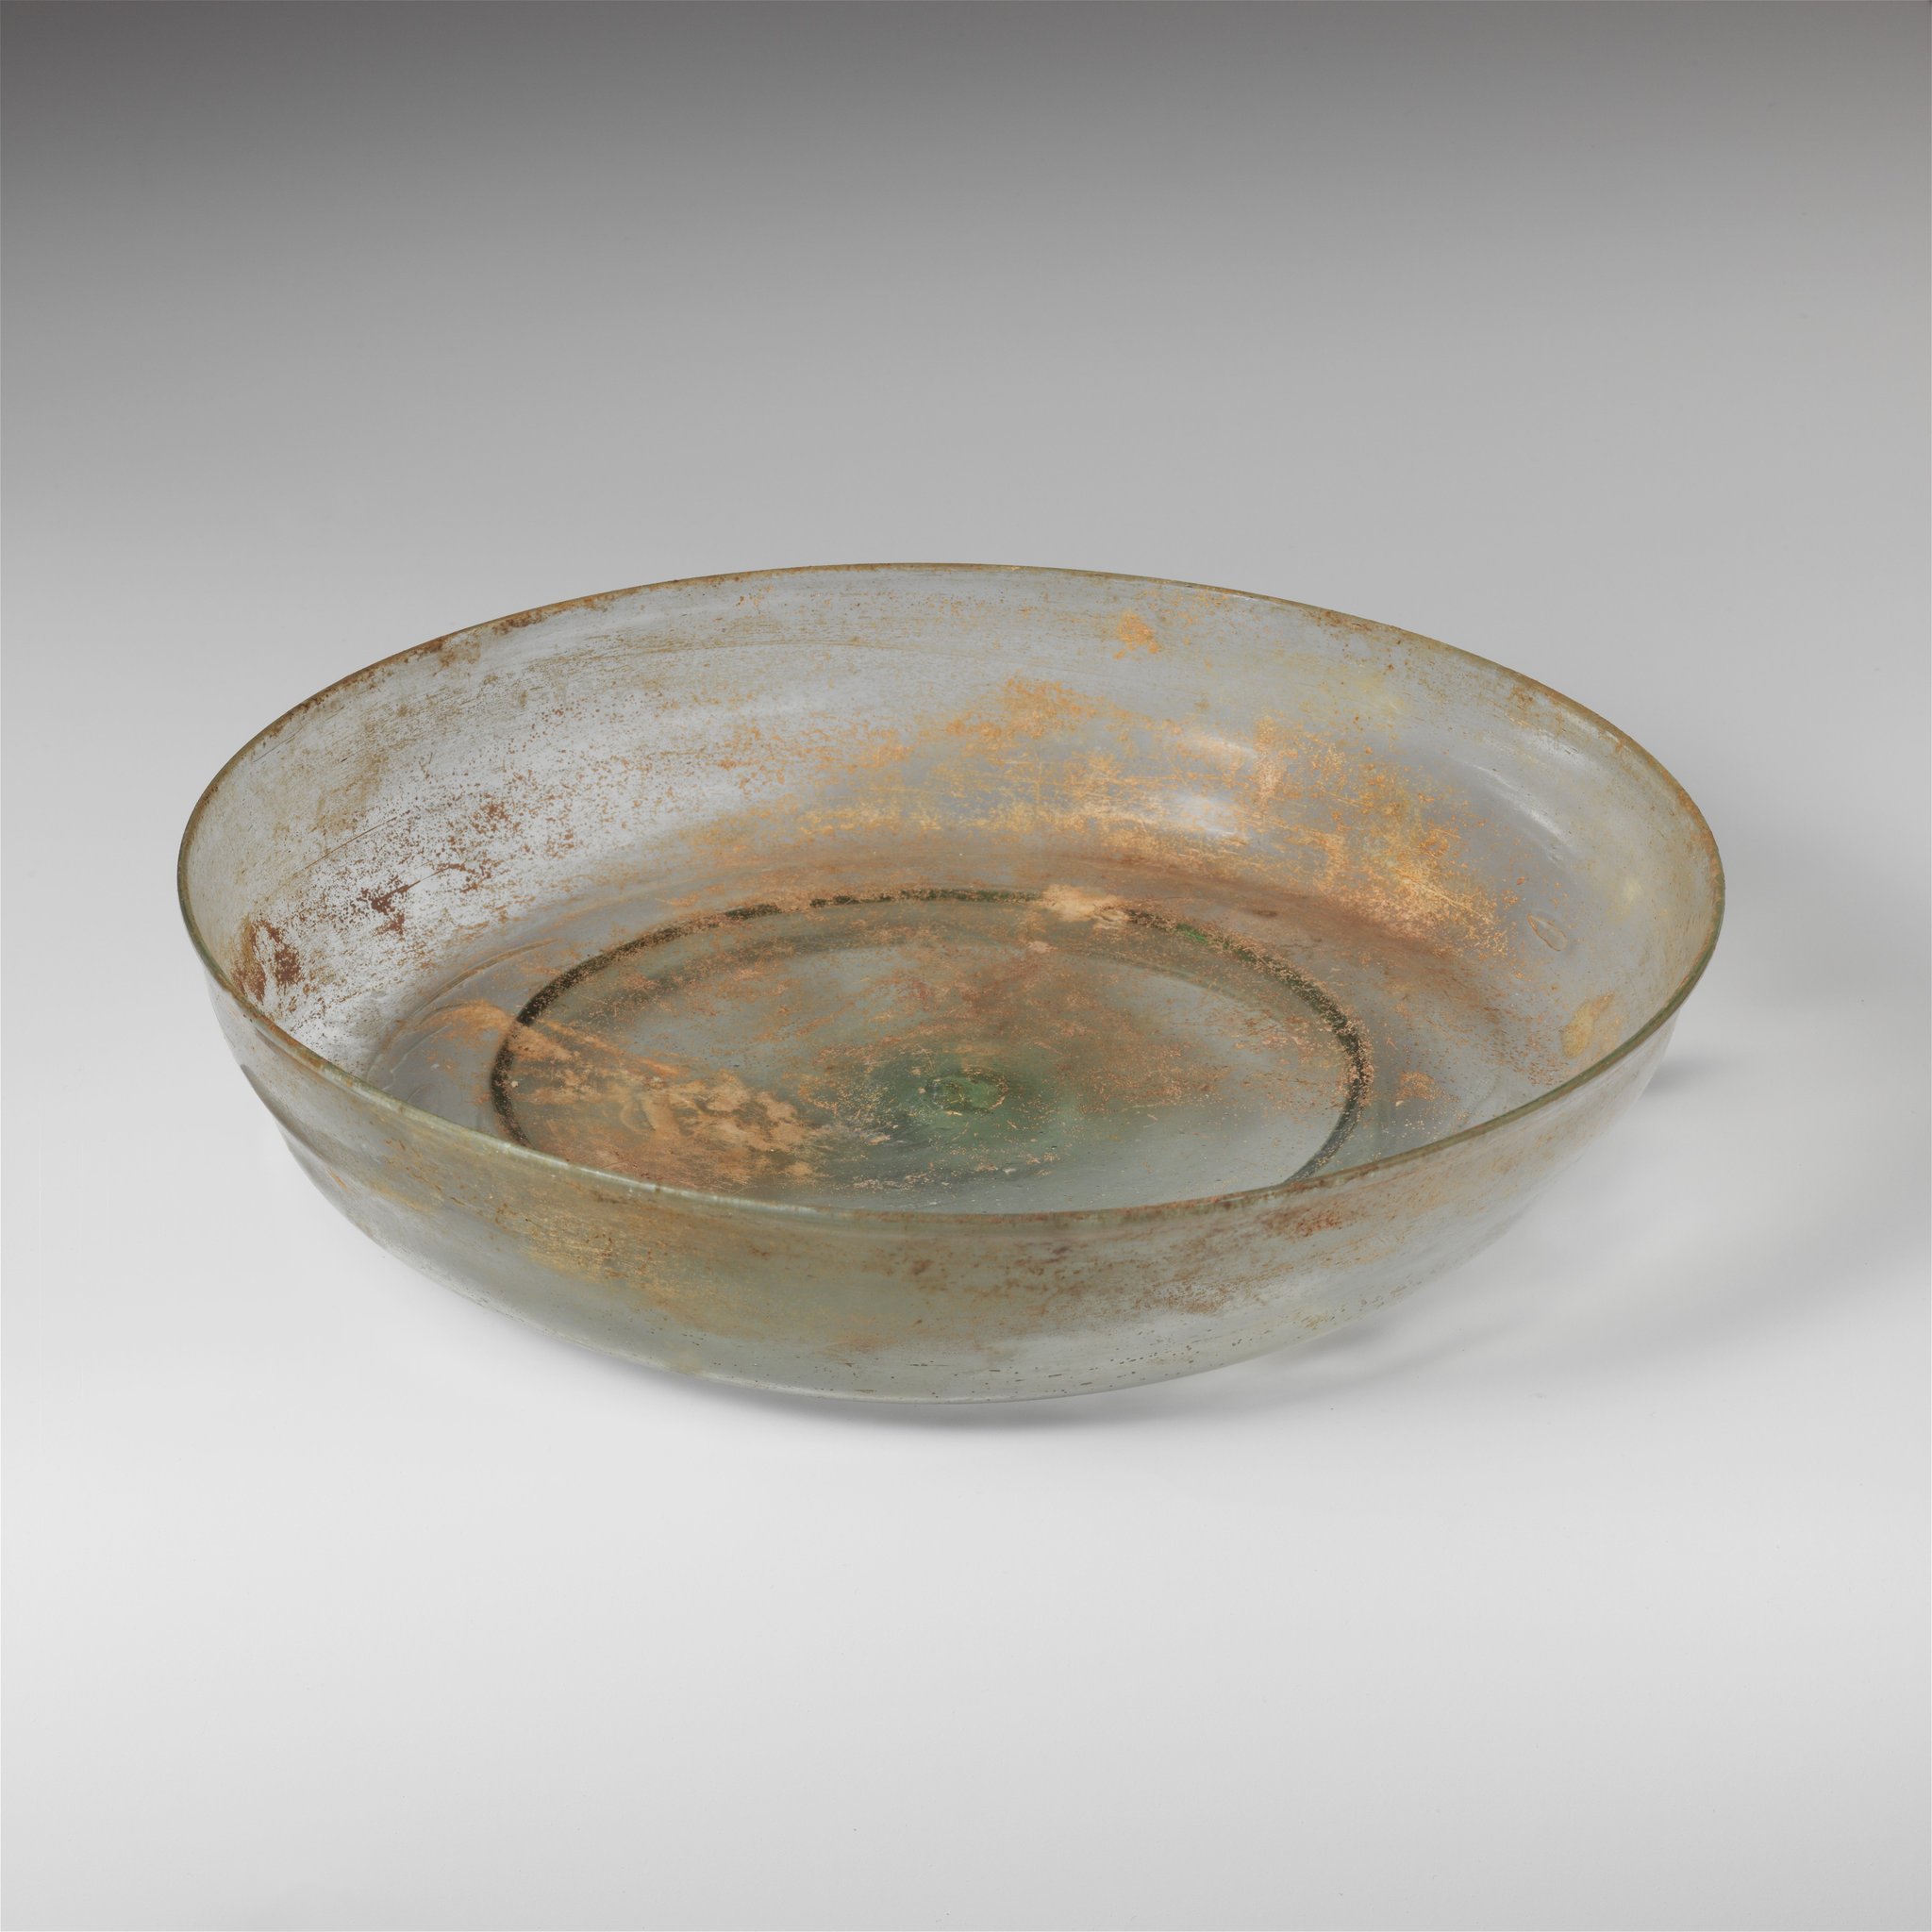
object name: dish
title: Glass dish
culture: roman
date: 301-400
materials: glass